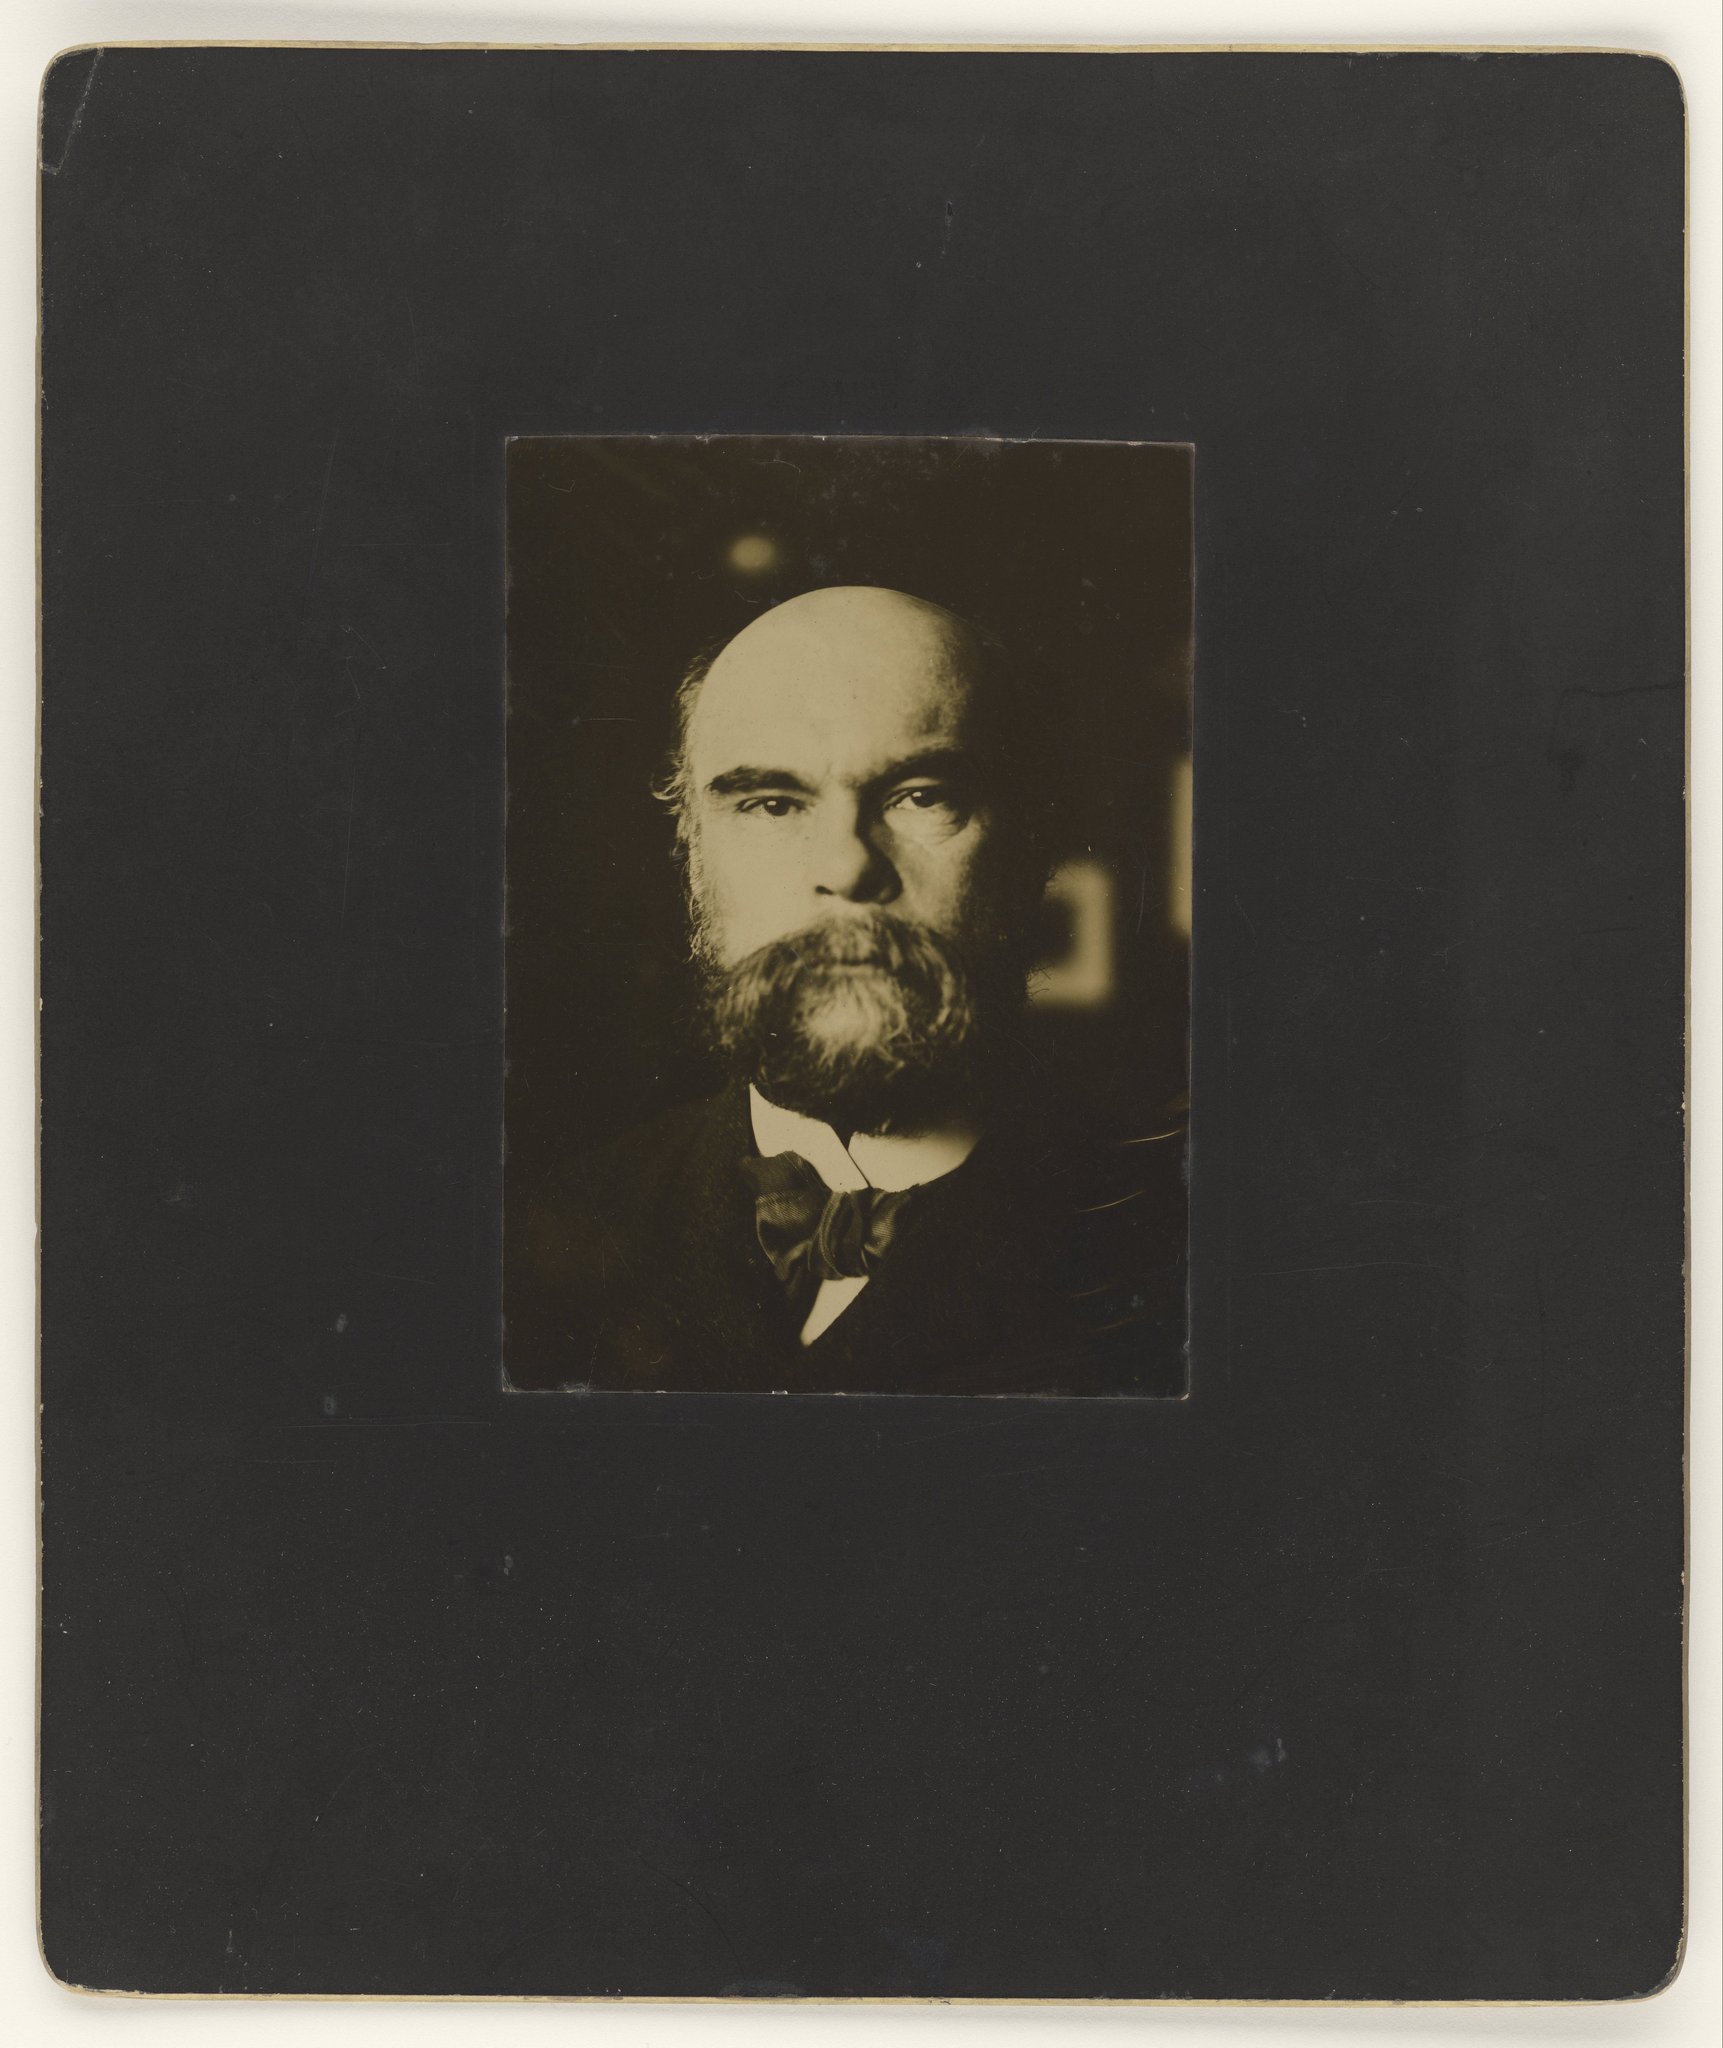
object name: photograph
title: Portraits of Lise Jordan, George Hendrik Breitner, Lise Jordan, Jaap Batavier, Hein Boeken, Paul Verlaine and Herman Gorter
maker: willem witsen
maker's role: draughtsman, painter, print maker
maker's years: 1860-1923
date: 1892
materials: cardboard, paper, photographic support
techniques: gelatin silver print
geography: amsterdam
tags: paul verlaine, historical persons (portraits and scenes from the life)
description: Witsen was a painter, etcher, and engraver of Amsterdam city views. The writers known as De Tachtigers (Literary Movement of Eighteen Eighties) and the artists’ models Marie and Lise Jordan met in his studio. In his free time Witsen photographed his friends in a way he had cribbed from Joseph Jessurun de Mesquita, who died young. He experimented endlessly, for instance with heads filling the picture plane and seen close up. He also managed to convince the French poet Verlaine to pose in front of his camera.